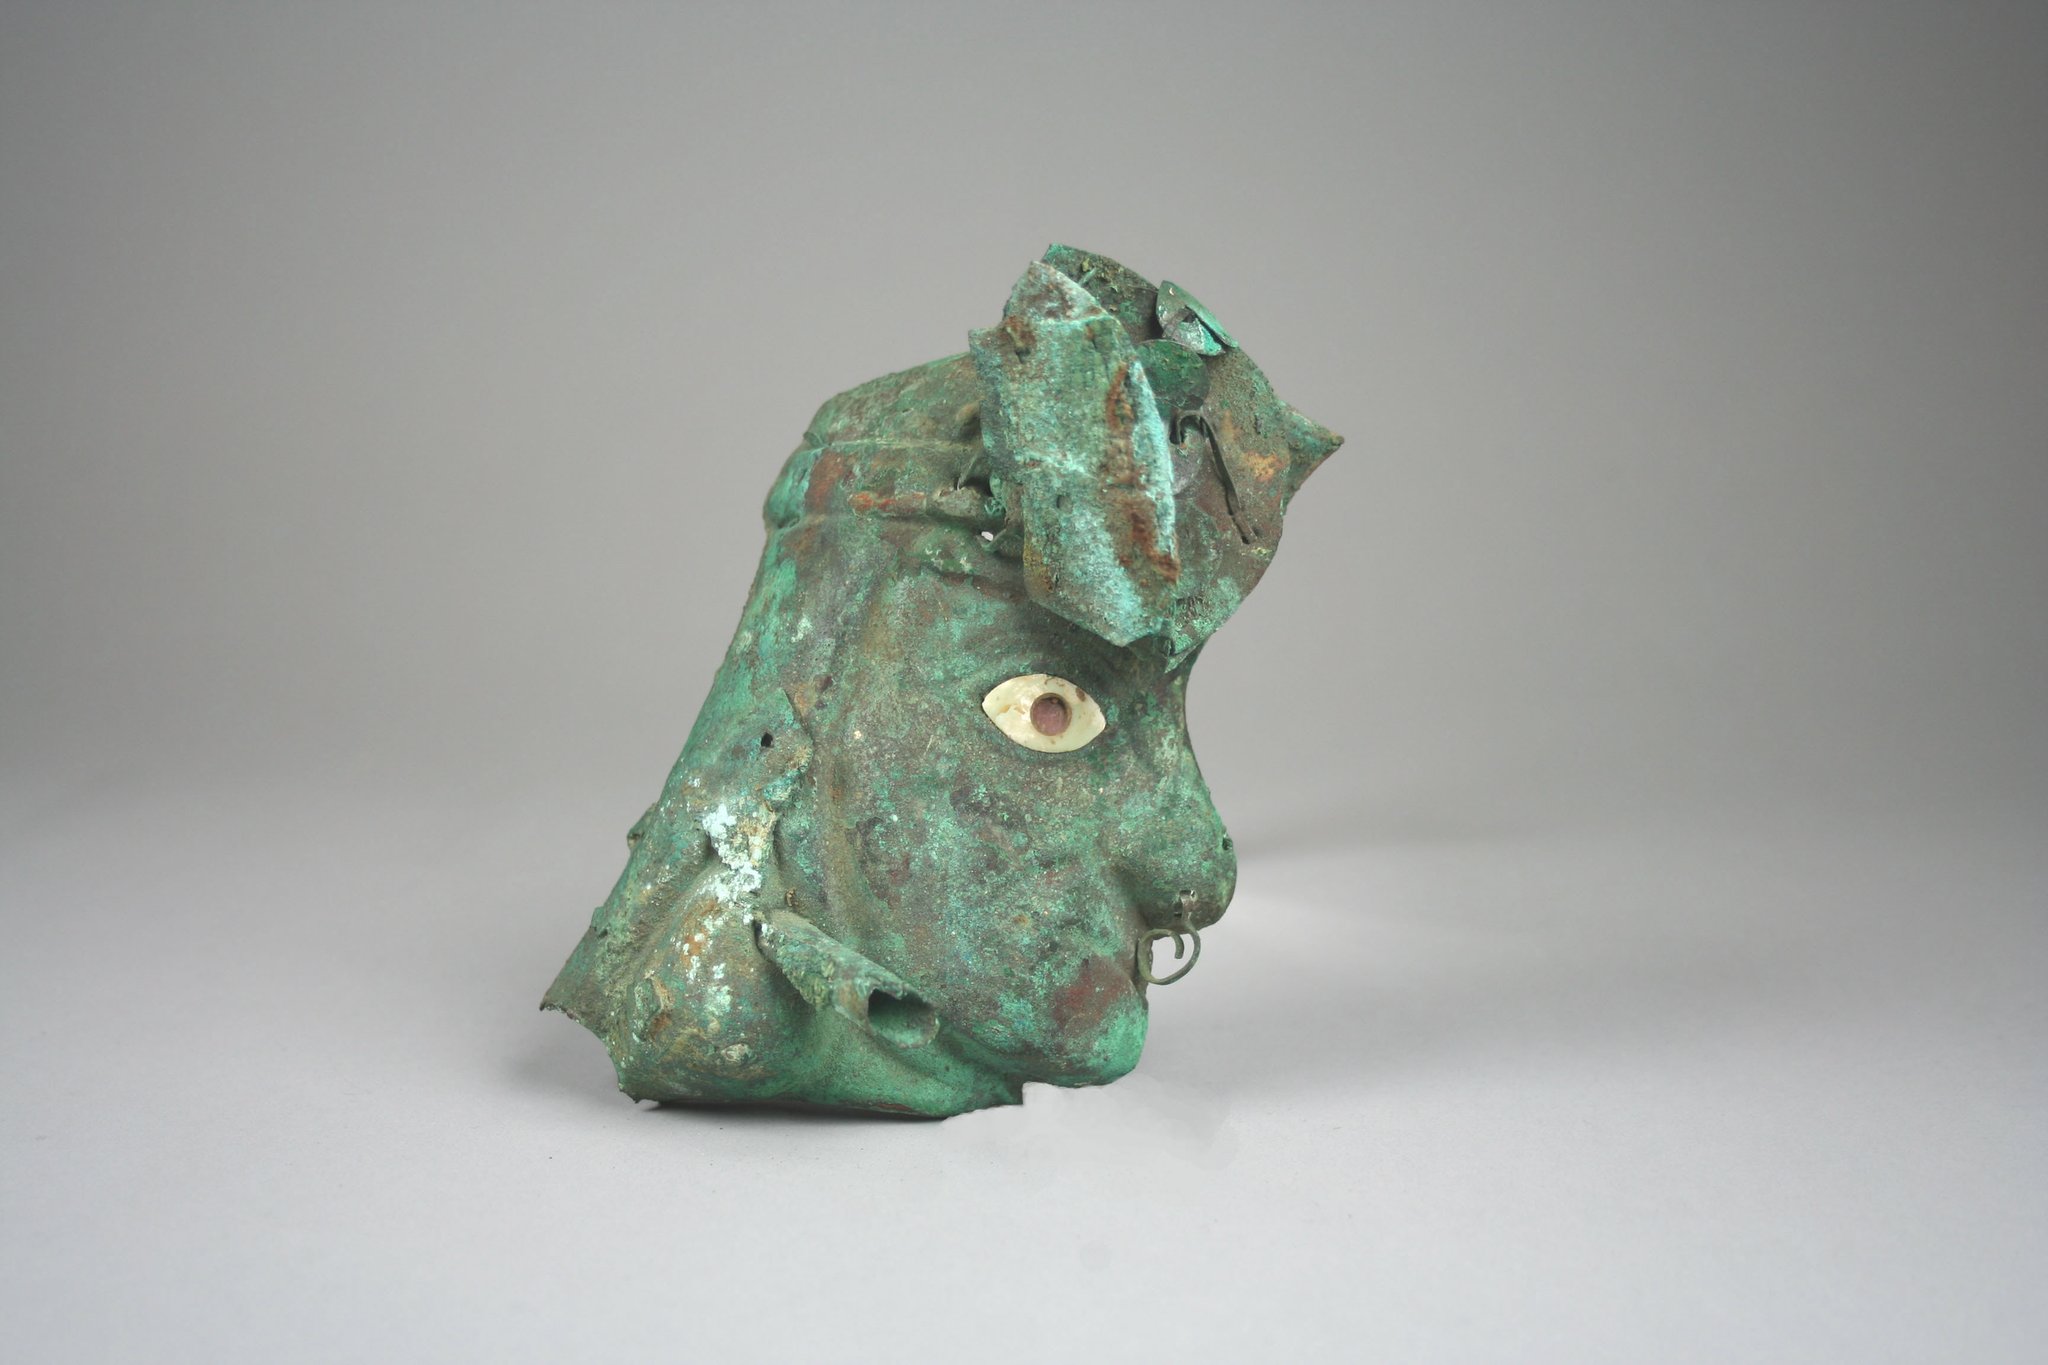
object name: ornament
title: Face Mask Ornament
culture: moche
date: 501-700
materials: copper, shell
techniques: gilding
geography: peru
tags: masks,faces